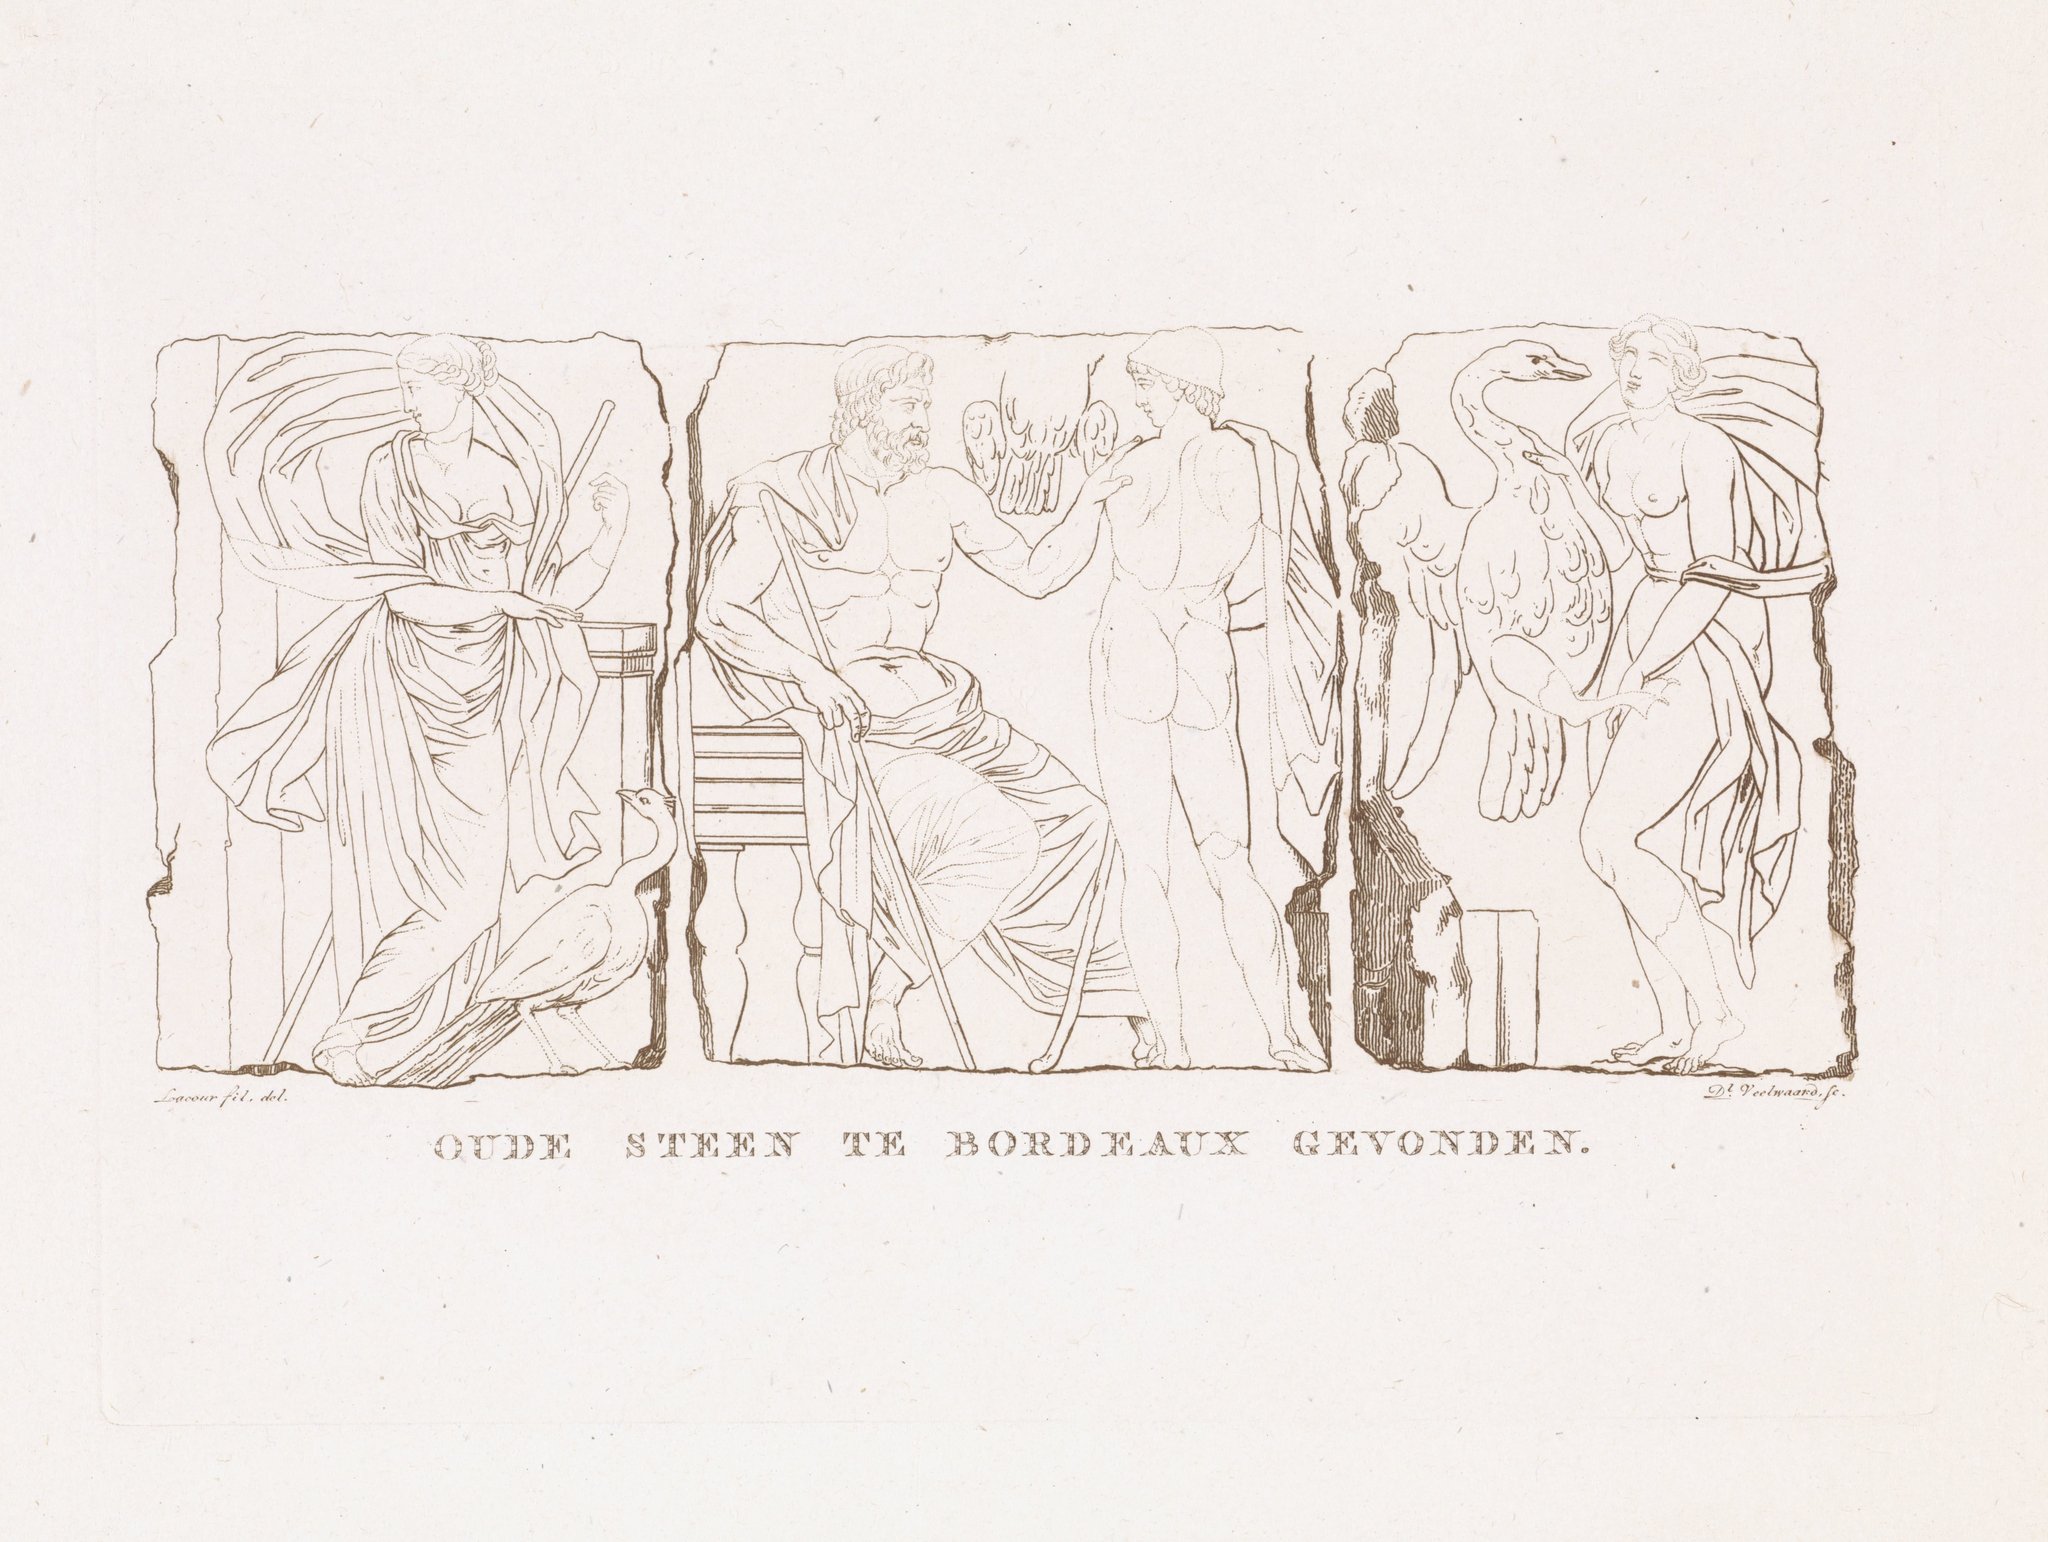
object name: print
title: Oude steen te Bordeuax gevonden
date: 1776-1851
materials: paper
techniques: etching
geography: amsterdam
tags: attributes of juno, clay tablet, stone tablet, jupiter, in the shape of a swan, and leda, (story of) ganymede, (story of) mercury (hermes)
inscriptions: collector's mark: Lugt 2228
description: Drie voorstellingen op fragmenten van een antieke steen: Juno met pauw, Zeus met Mercurius of Ganymedes (?) en Leda met de zwaan.